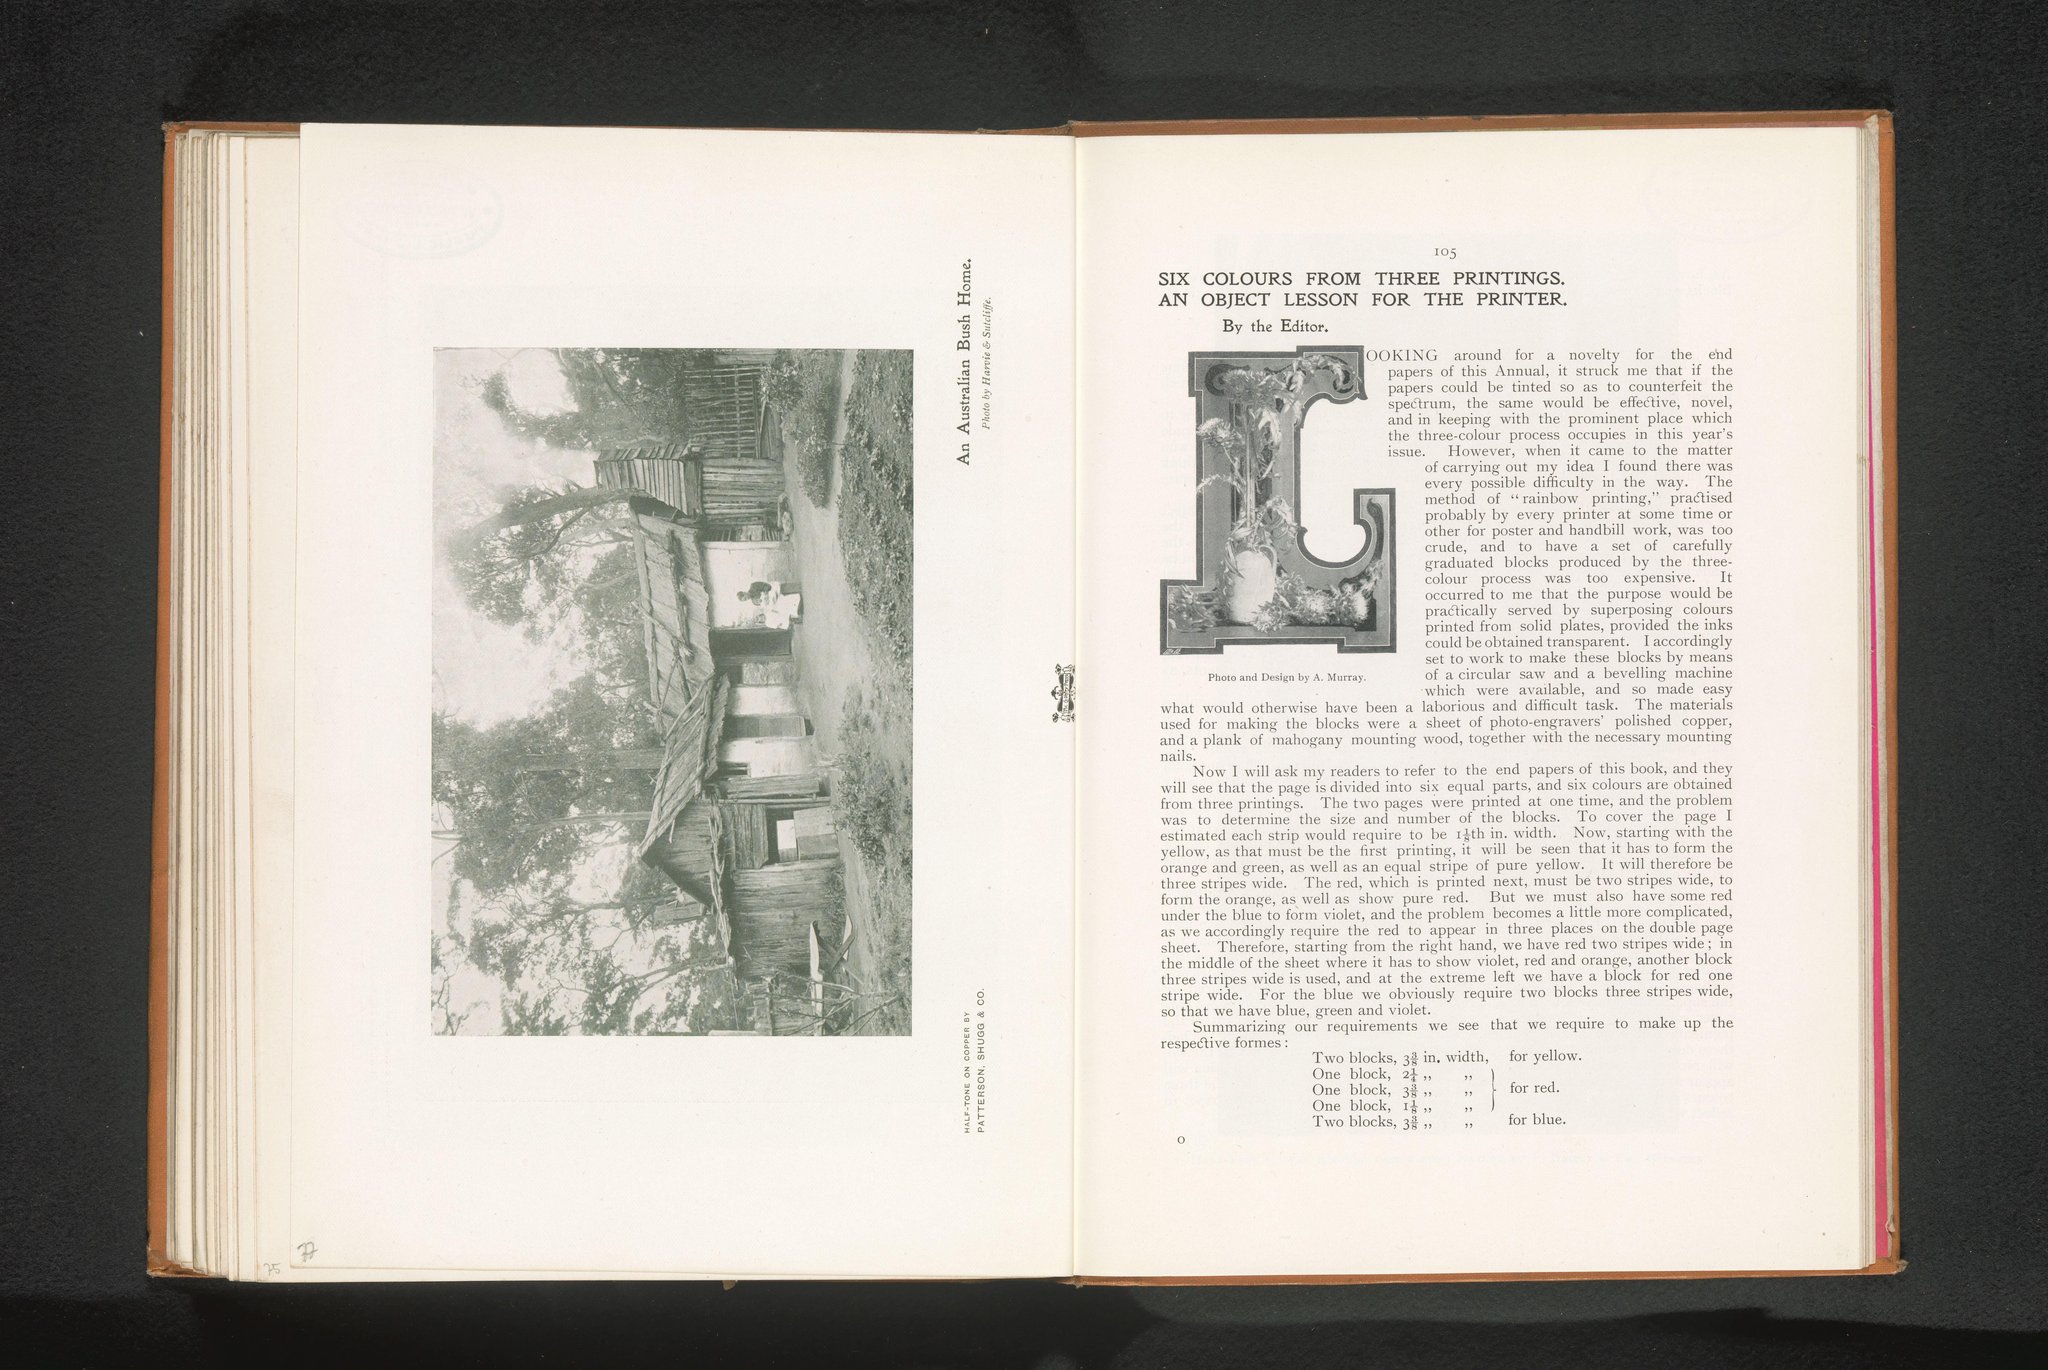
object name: photomechanical print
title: Gezicht op een plattelandswoning in Australië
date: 1894-1899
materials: paper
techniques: autotype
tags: rural housing, e.g. country-house, villa, cottage